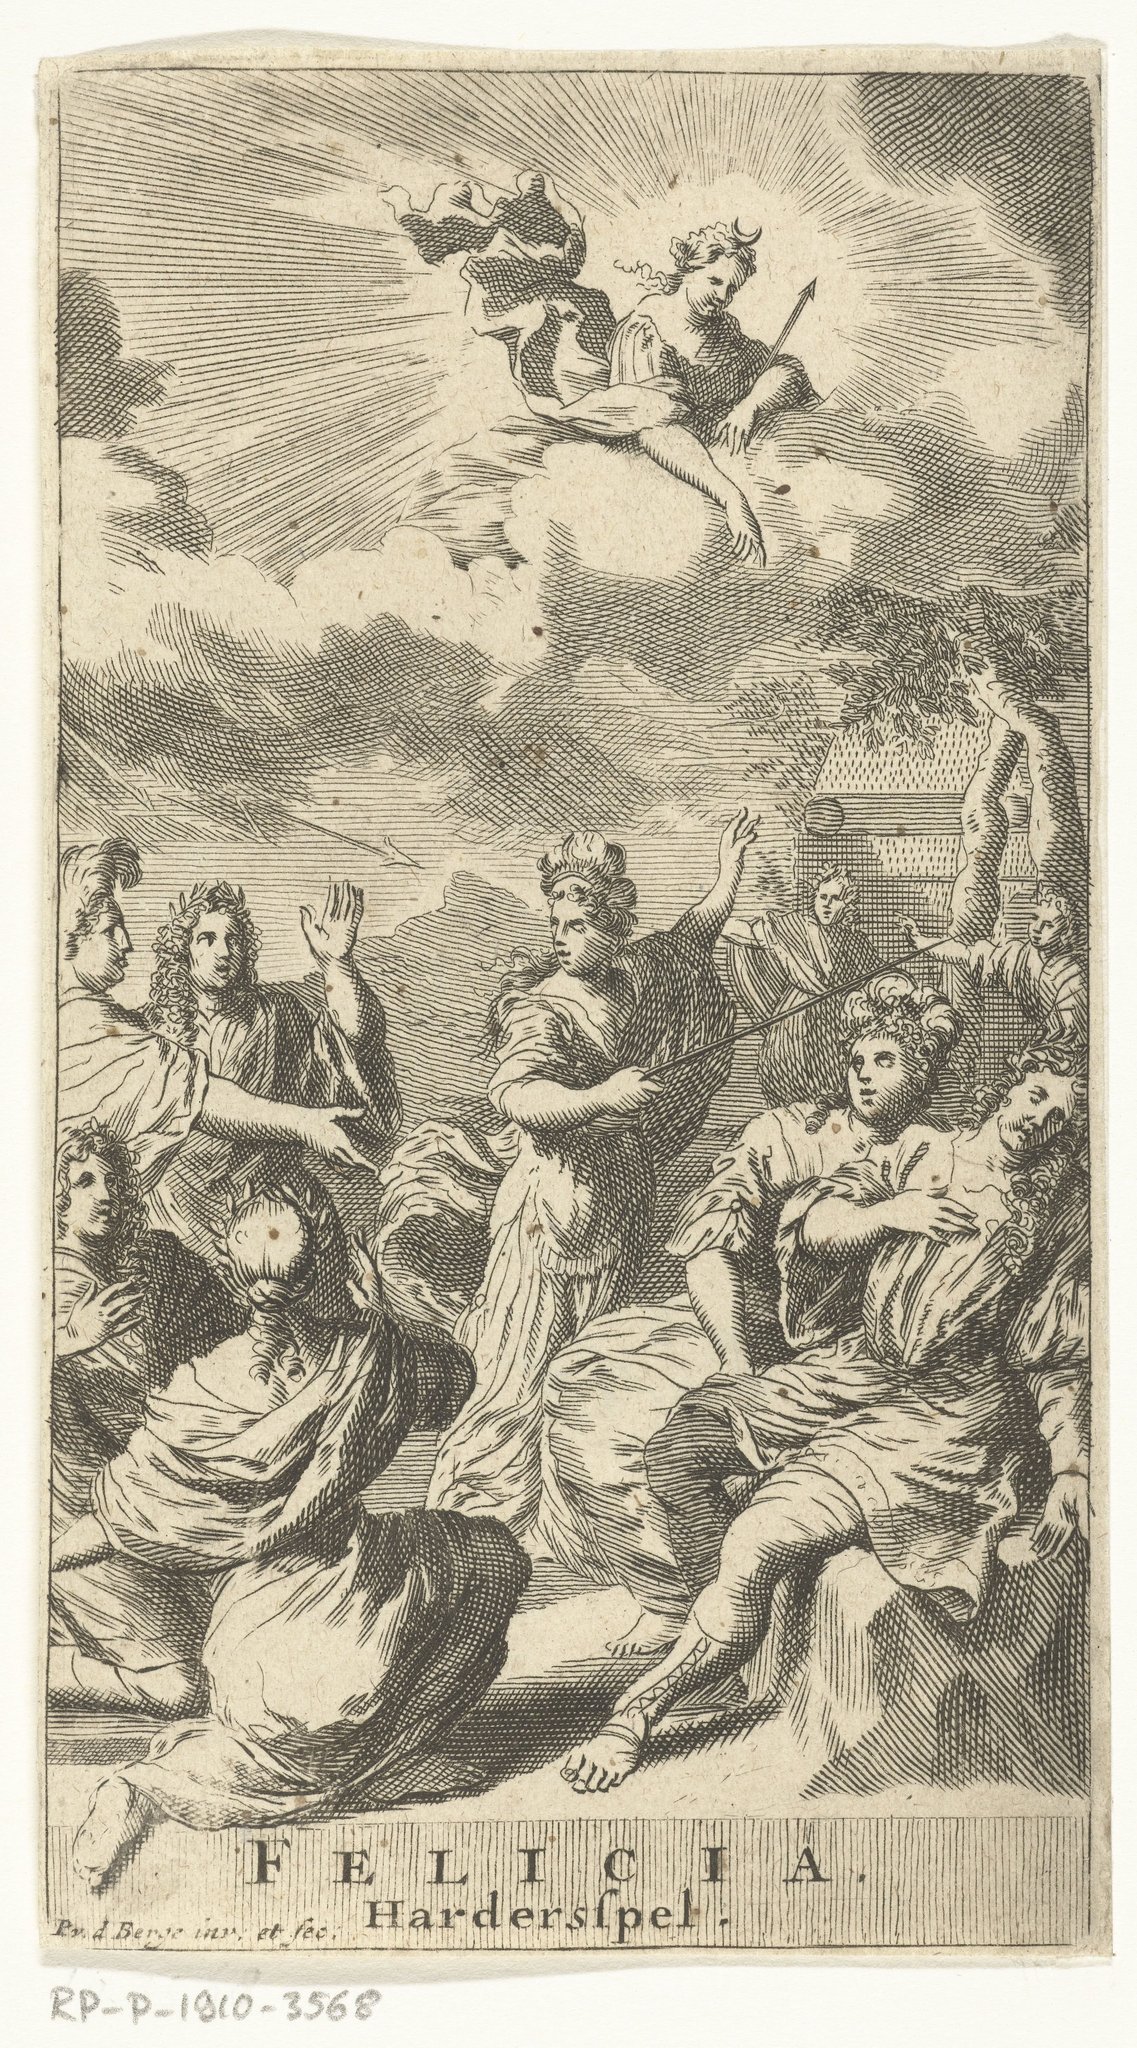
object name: titelblad, titelpagina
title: Titelpagina voor Felicia, of De betoveringe door liefde. Hardersspel, Amsterdam 1699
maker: pieter van den berge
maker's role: draughtsman, print maker, printer, publisher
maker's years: 1659-1737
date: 1699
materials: paper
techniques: engraving, etching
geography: amsterdam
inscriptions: collector's mark: Lugt 2228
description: Een groep mannen en vrouwen zit buiten. Een vrouw staat in het midden en gooit een bal in de lucht, ze houdt een stok in haar hand. Vanuit de hemel komt bliksem op haar af.